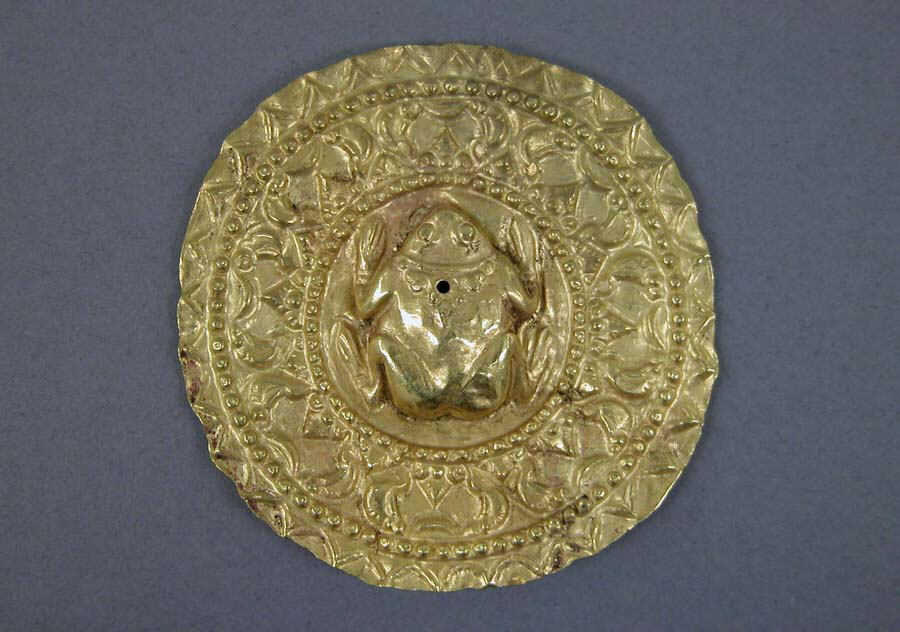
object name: disk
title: Disk or Subang Cover with Frog Surrounded by Foliate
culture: indonesian, javanese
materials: gold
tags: frogs